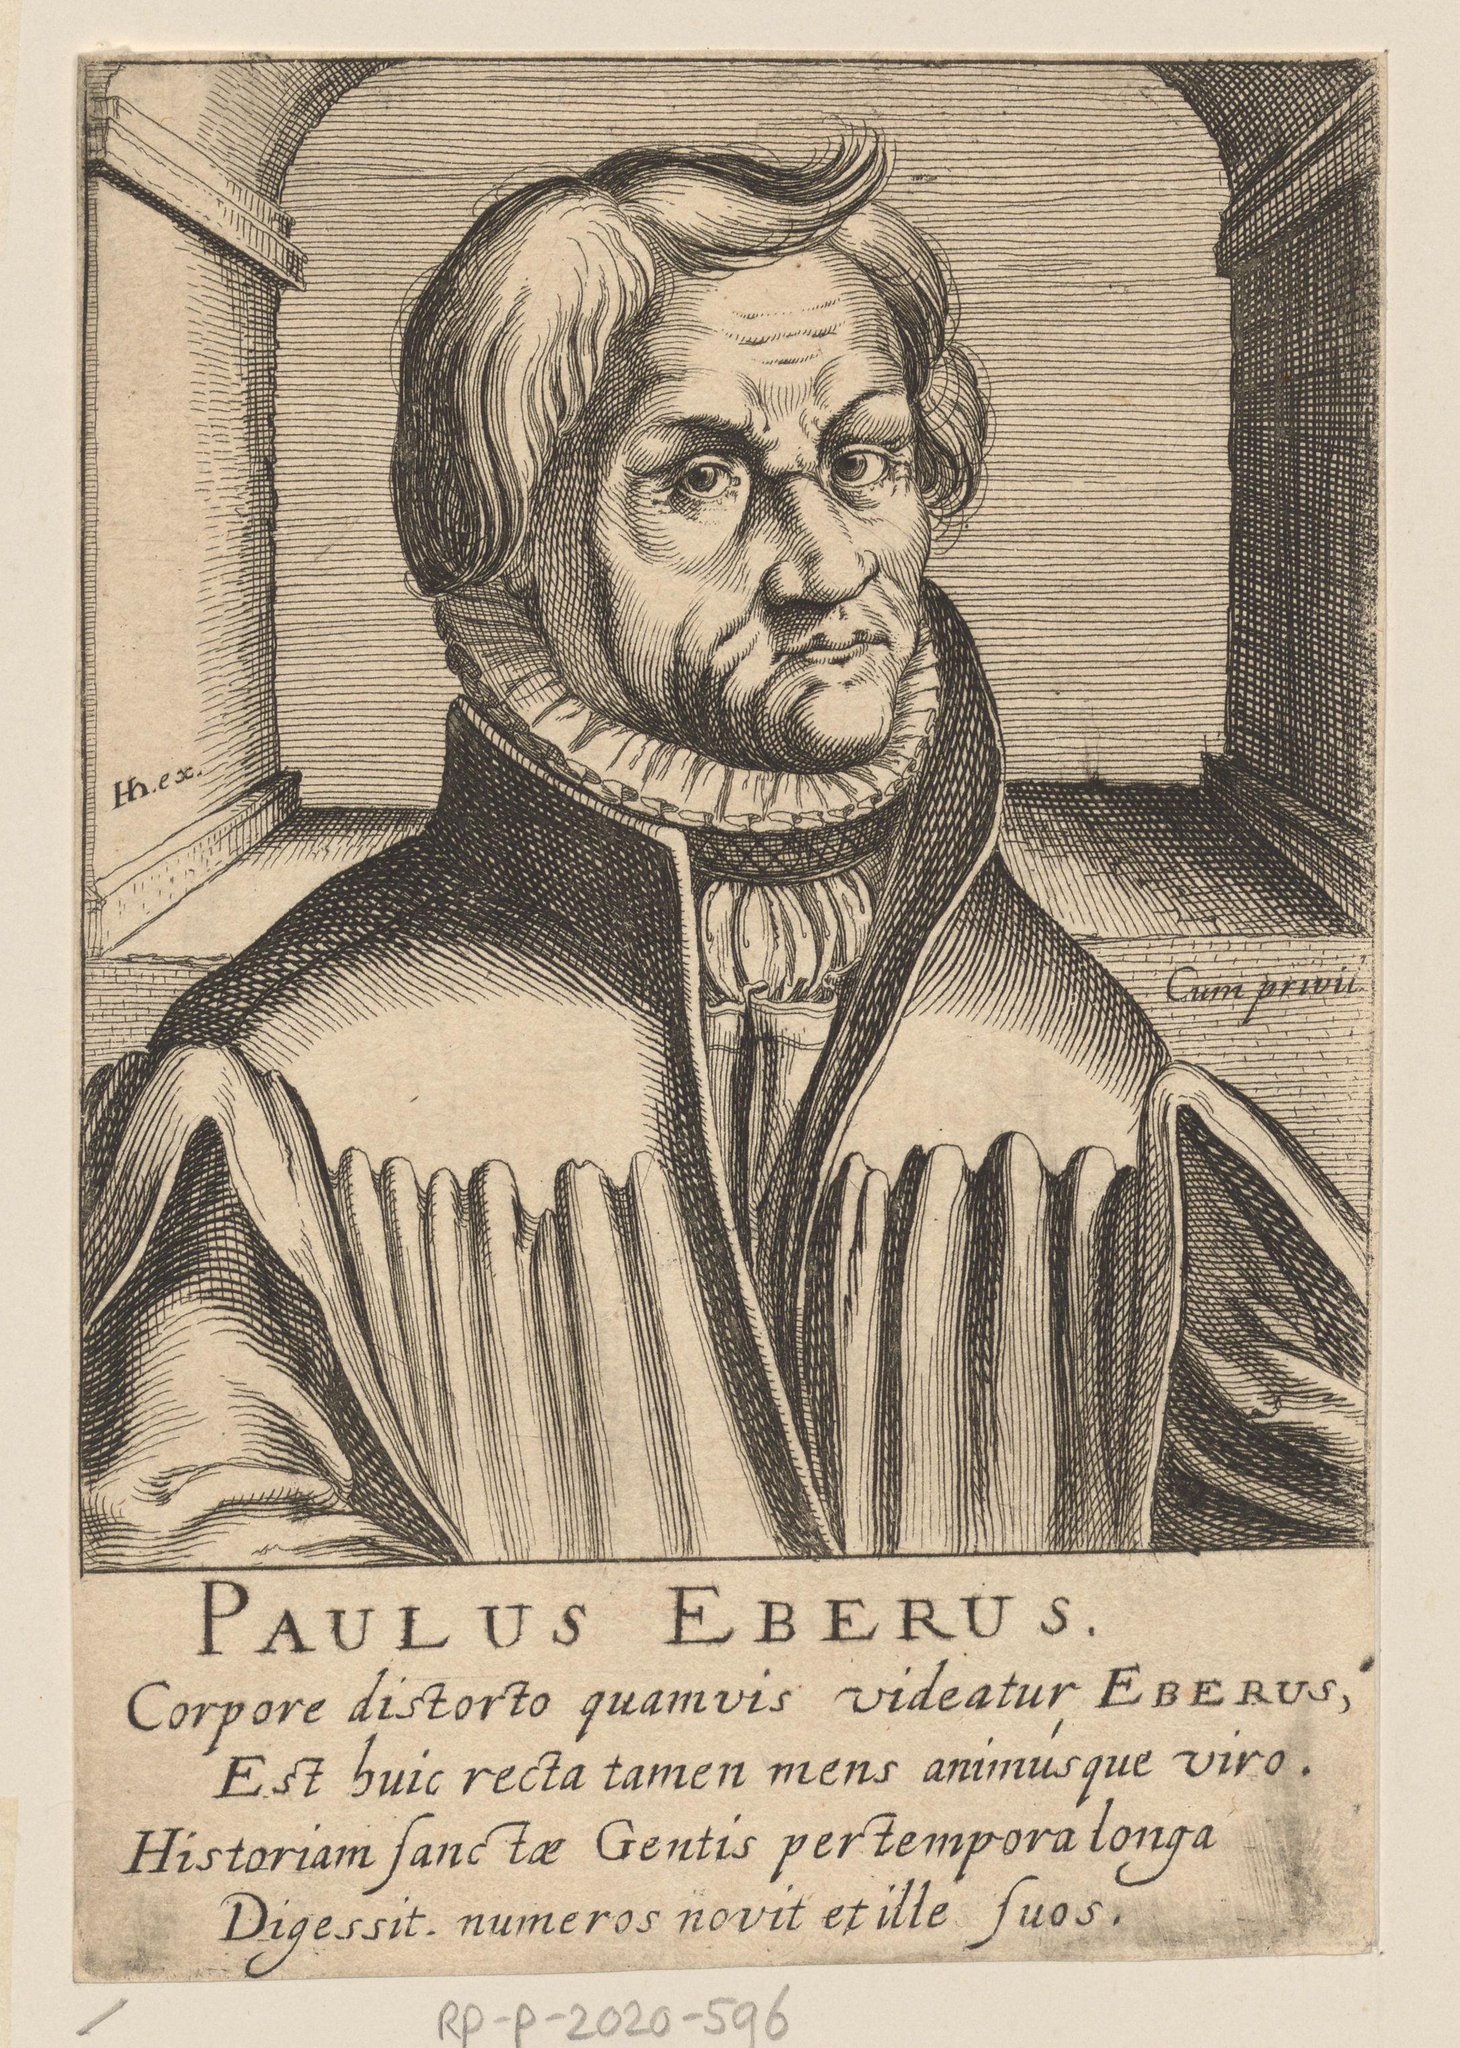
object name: print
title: Portret van Paul Eber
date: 1610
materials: paper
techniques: etching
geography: the hague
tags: theologian, historical persons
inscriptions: collector's mark: Lugt 2228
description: De prenten uit deze serie werden vermoedelijk toegevoegd aan Hondius' eerdere serie 'Icones Vivorum Nostra Patrumq. Memoria Illustrium' (1599).